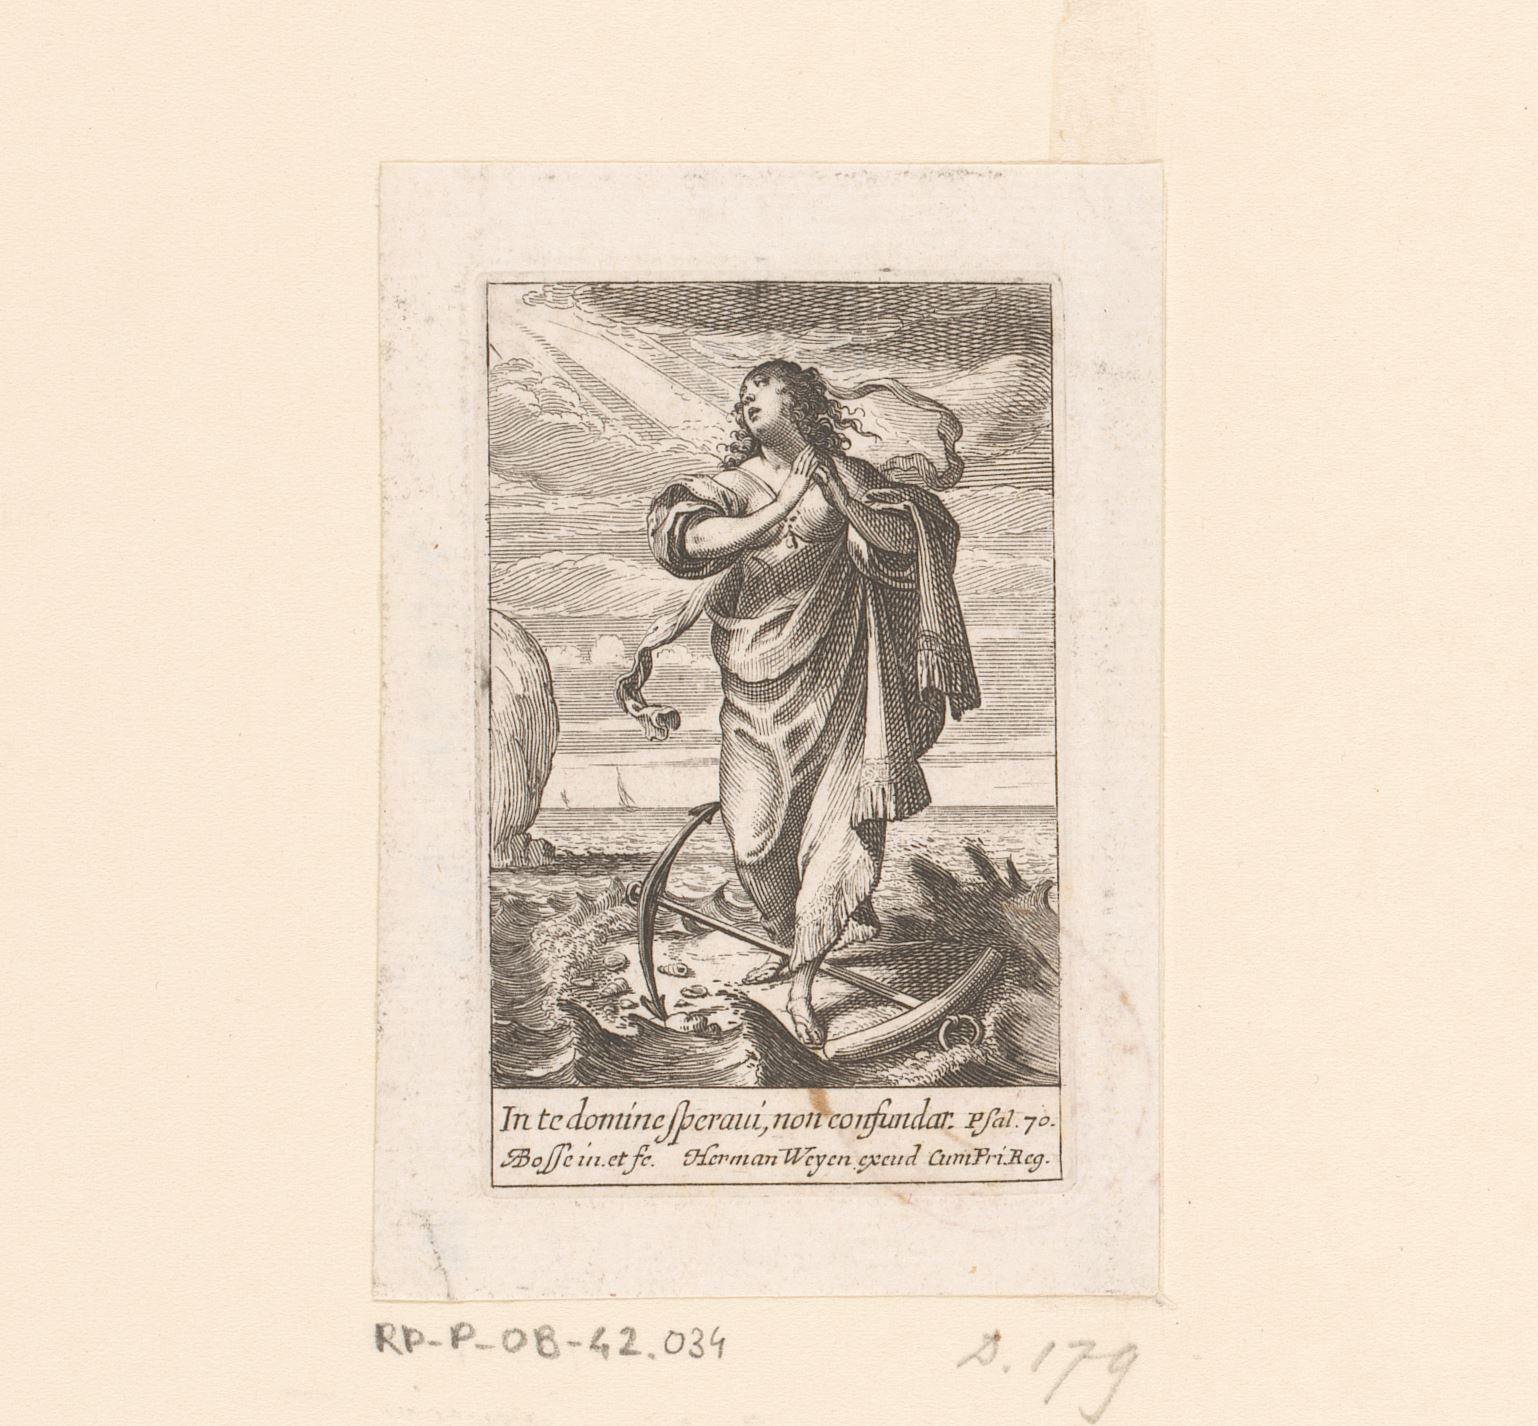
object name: print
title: Personificaties van deugden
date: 1636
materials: paper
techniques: engraving, etching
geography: paris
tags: hope, 'spes'; 'speranza divina e certa' (ripa) ~ one of the three theological virtues, the seven virtues (symbolized)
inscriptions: collector's mark: Lugt 240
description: Maakt deel uit van een serie van negen prenten (inclusief twee titelprenten) met personificaties van de zeven deugden.